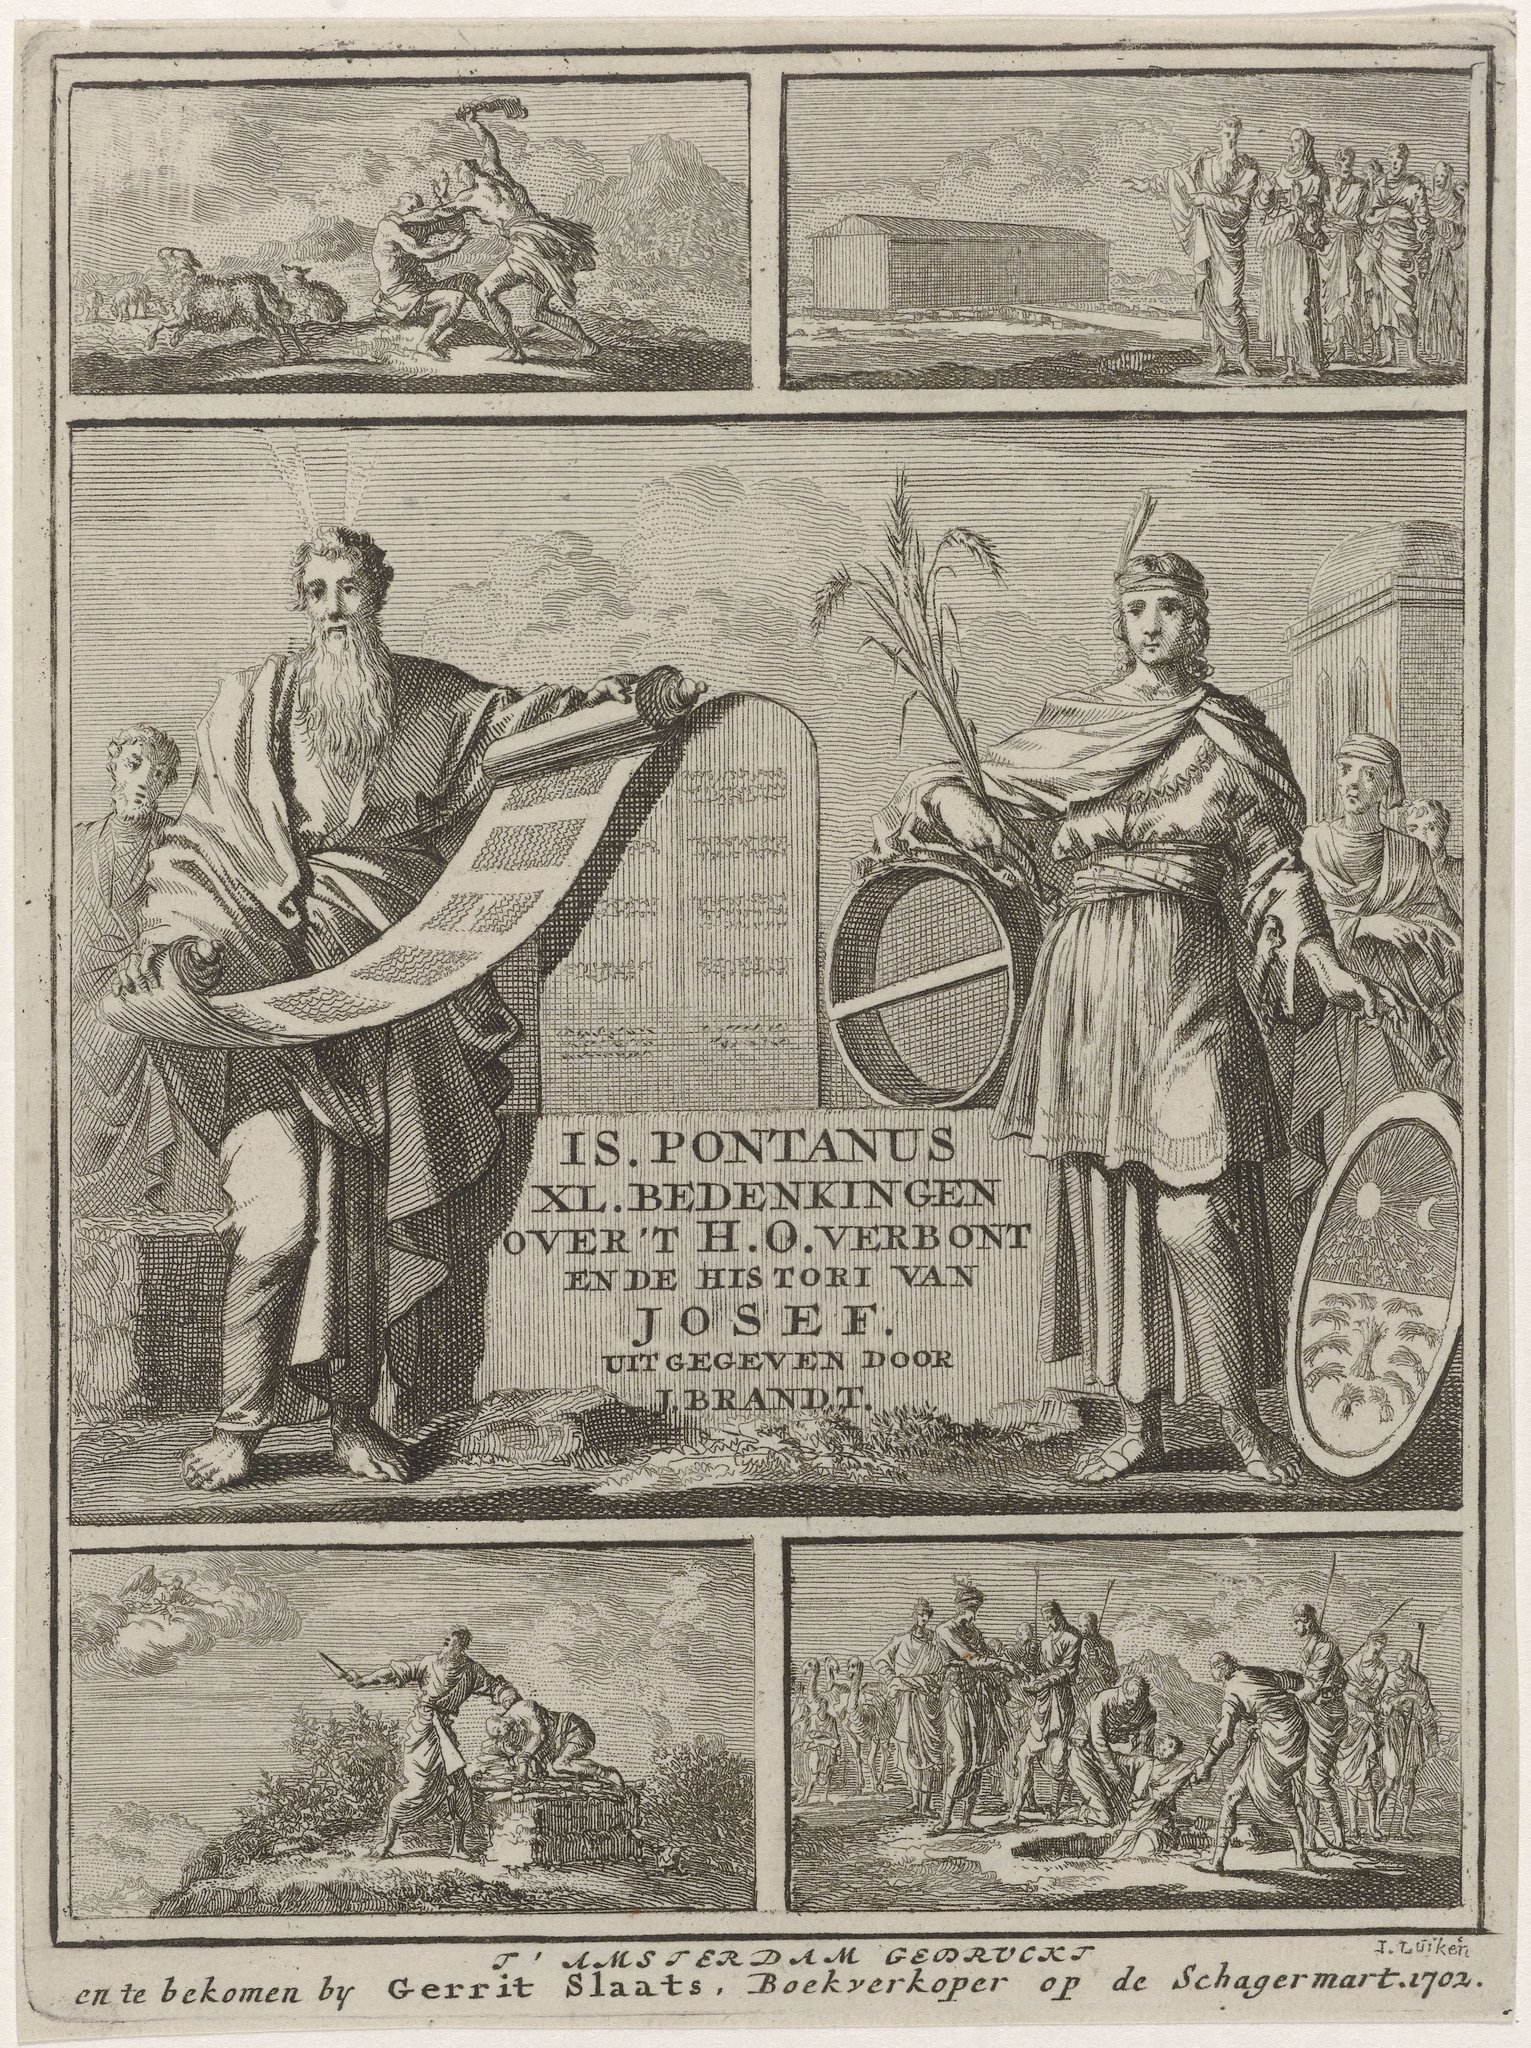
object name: titelblad, titelpagina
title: Titelpagina voor Isaak Pontanus, XL bedenkingen over verscheide stoffen van het H. out verbont, eindigende met de histori van Josefs leven, 1702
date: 1702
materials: paper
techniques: etching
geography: haarlem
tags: the killing of abel: cain slays him with a stone, a club or a jaw-bone, alternatively with a spade or another tool as weapon, the sacrifice of isaac (genesis 22), joseph is pulled out of the pit, moses (not in biblical context); possible attributes: rays of light or horns on his head, rod, tables of the law, noah building the ark, joseph (not in biblical context)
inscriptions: collector's mark: Lugt 2228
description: Links Mozes met in zijn handen een wetrol van de Torah. Naast hem de Tafelen der Wet. Rechts Jozef met in zijn handen een korenmaat en drie korenaren. Naast Jozef een schild met een voorstelling van zijn dromen. Tussen Mozes en Jozef de titel van het boekwerk. Rondom de hoofdvoorstelling vier scènes uit het Oude Testament.